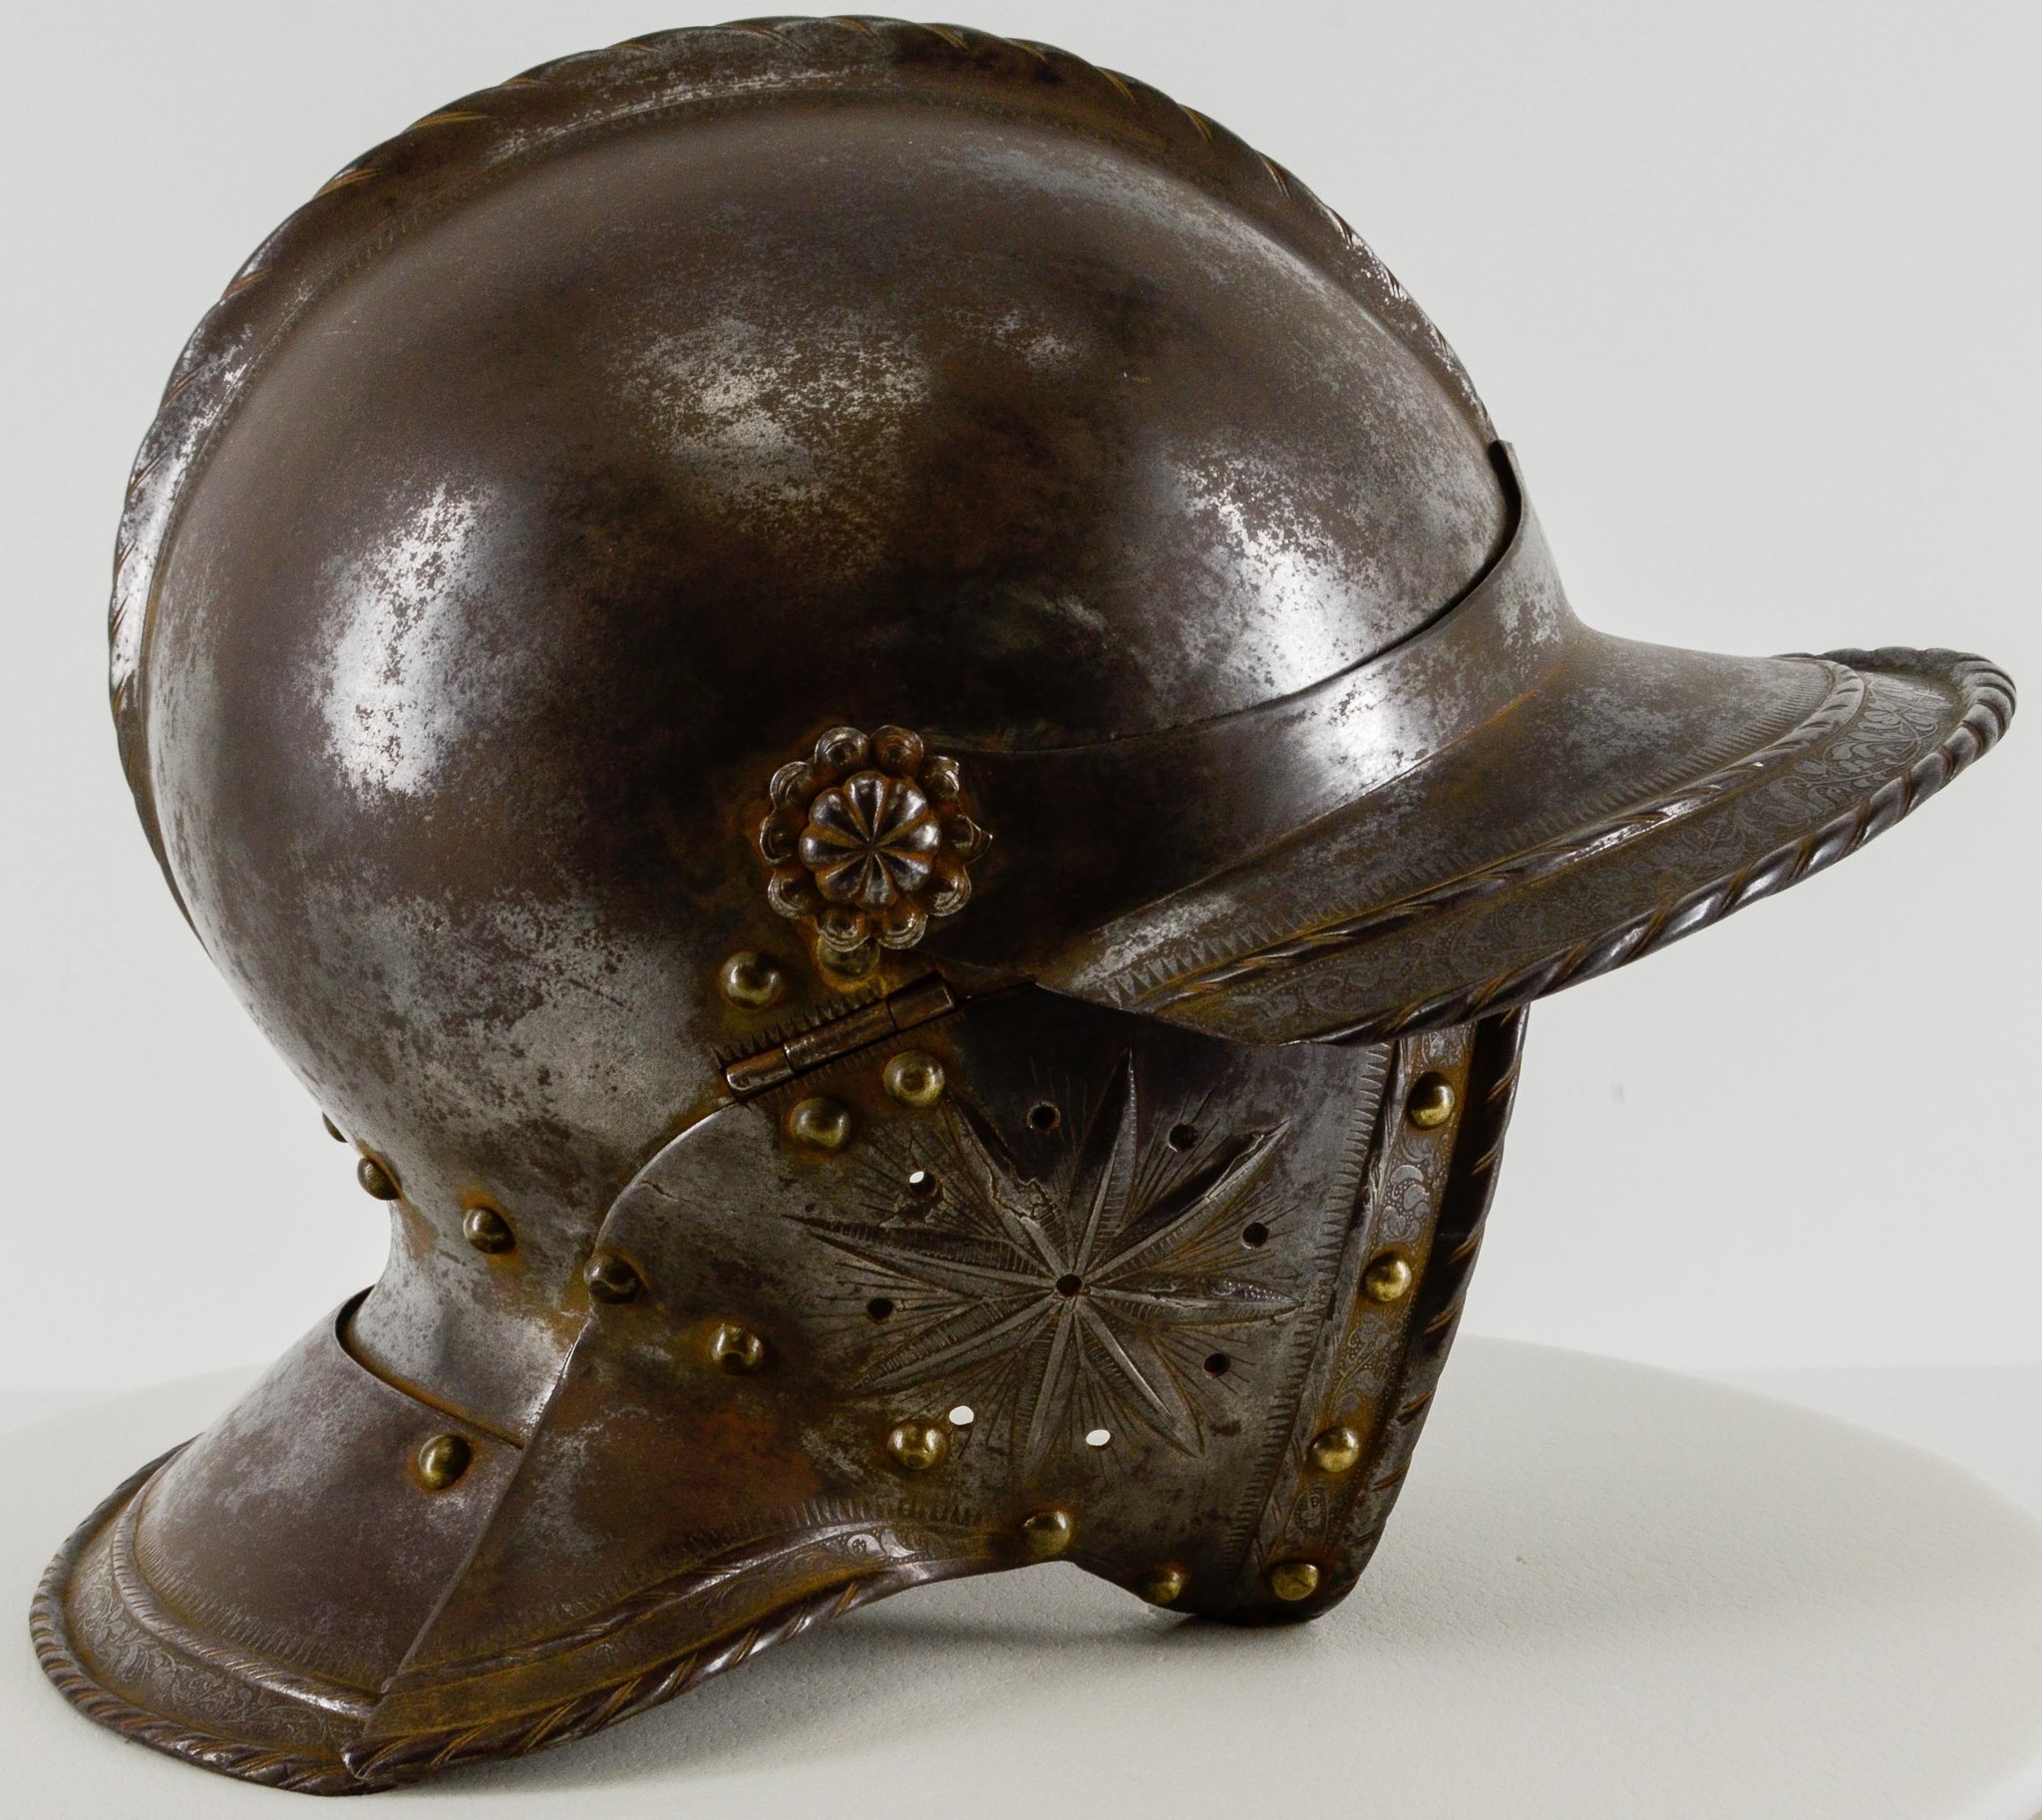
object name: burgonet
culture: german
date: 1525-1530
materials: copper alloy, leather, steel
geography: germany